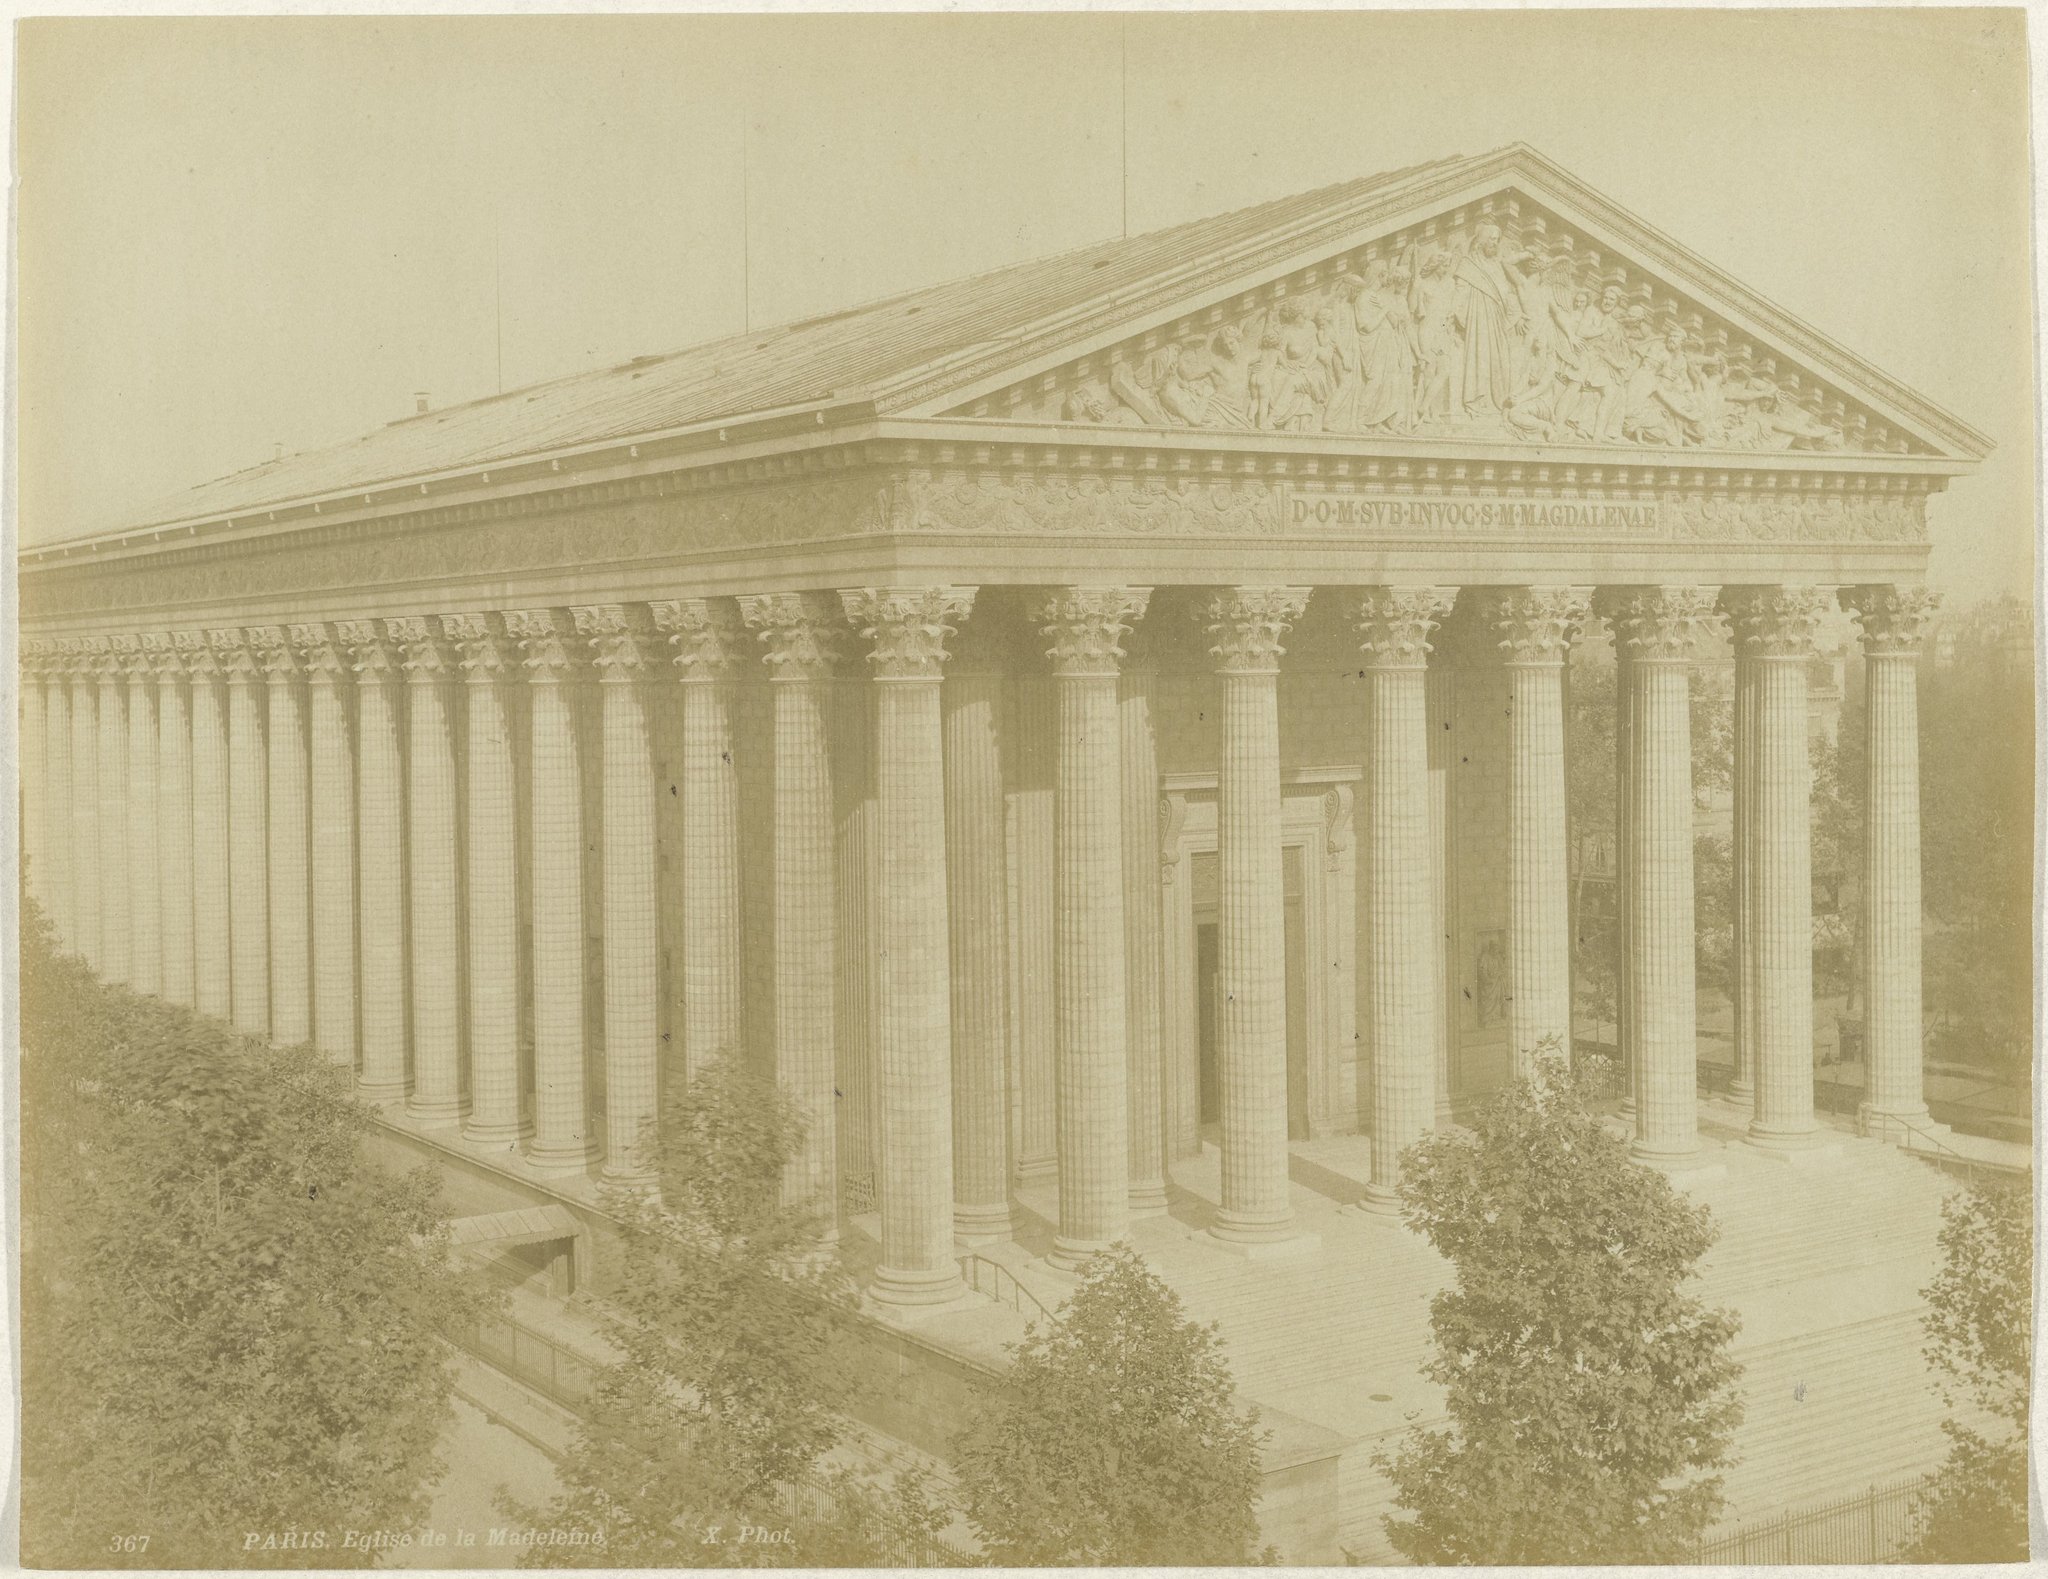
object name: photograph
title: Paris. Eglise de la Madeleine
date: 1887-1900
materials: paper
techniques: albumen print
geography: paris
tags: church (exterior)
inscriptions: inscription: ‘367 Paris. Eglise de la Madeleine. X. Phot.’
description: Tussen 1887 en ca. 1900 werkten Neurdein frères onder andere onder de naam 'X phot.'.